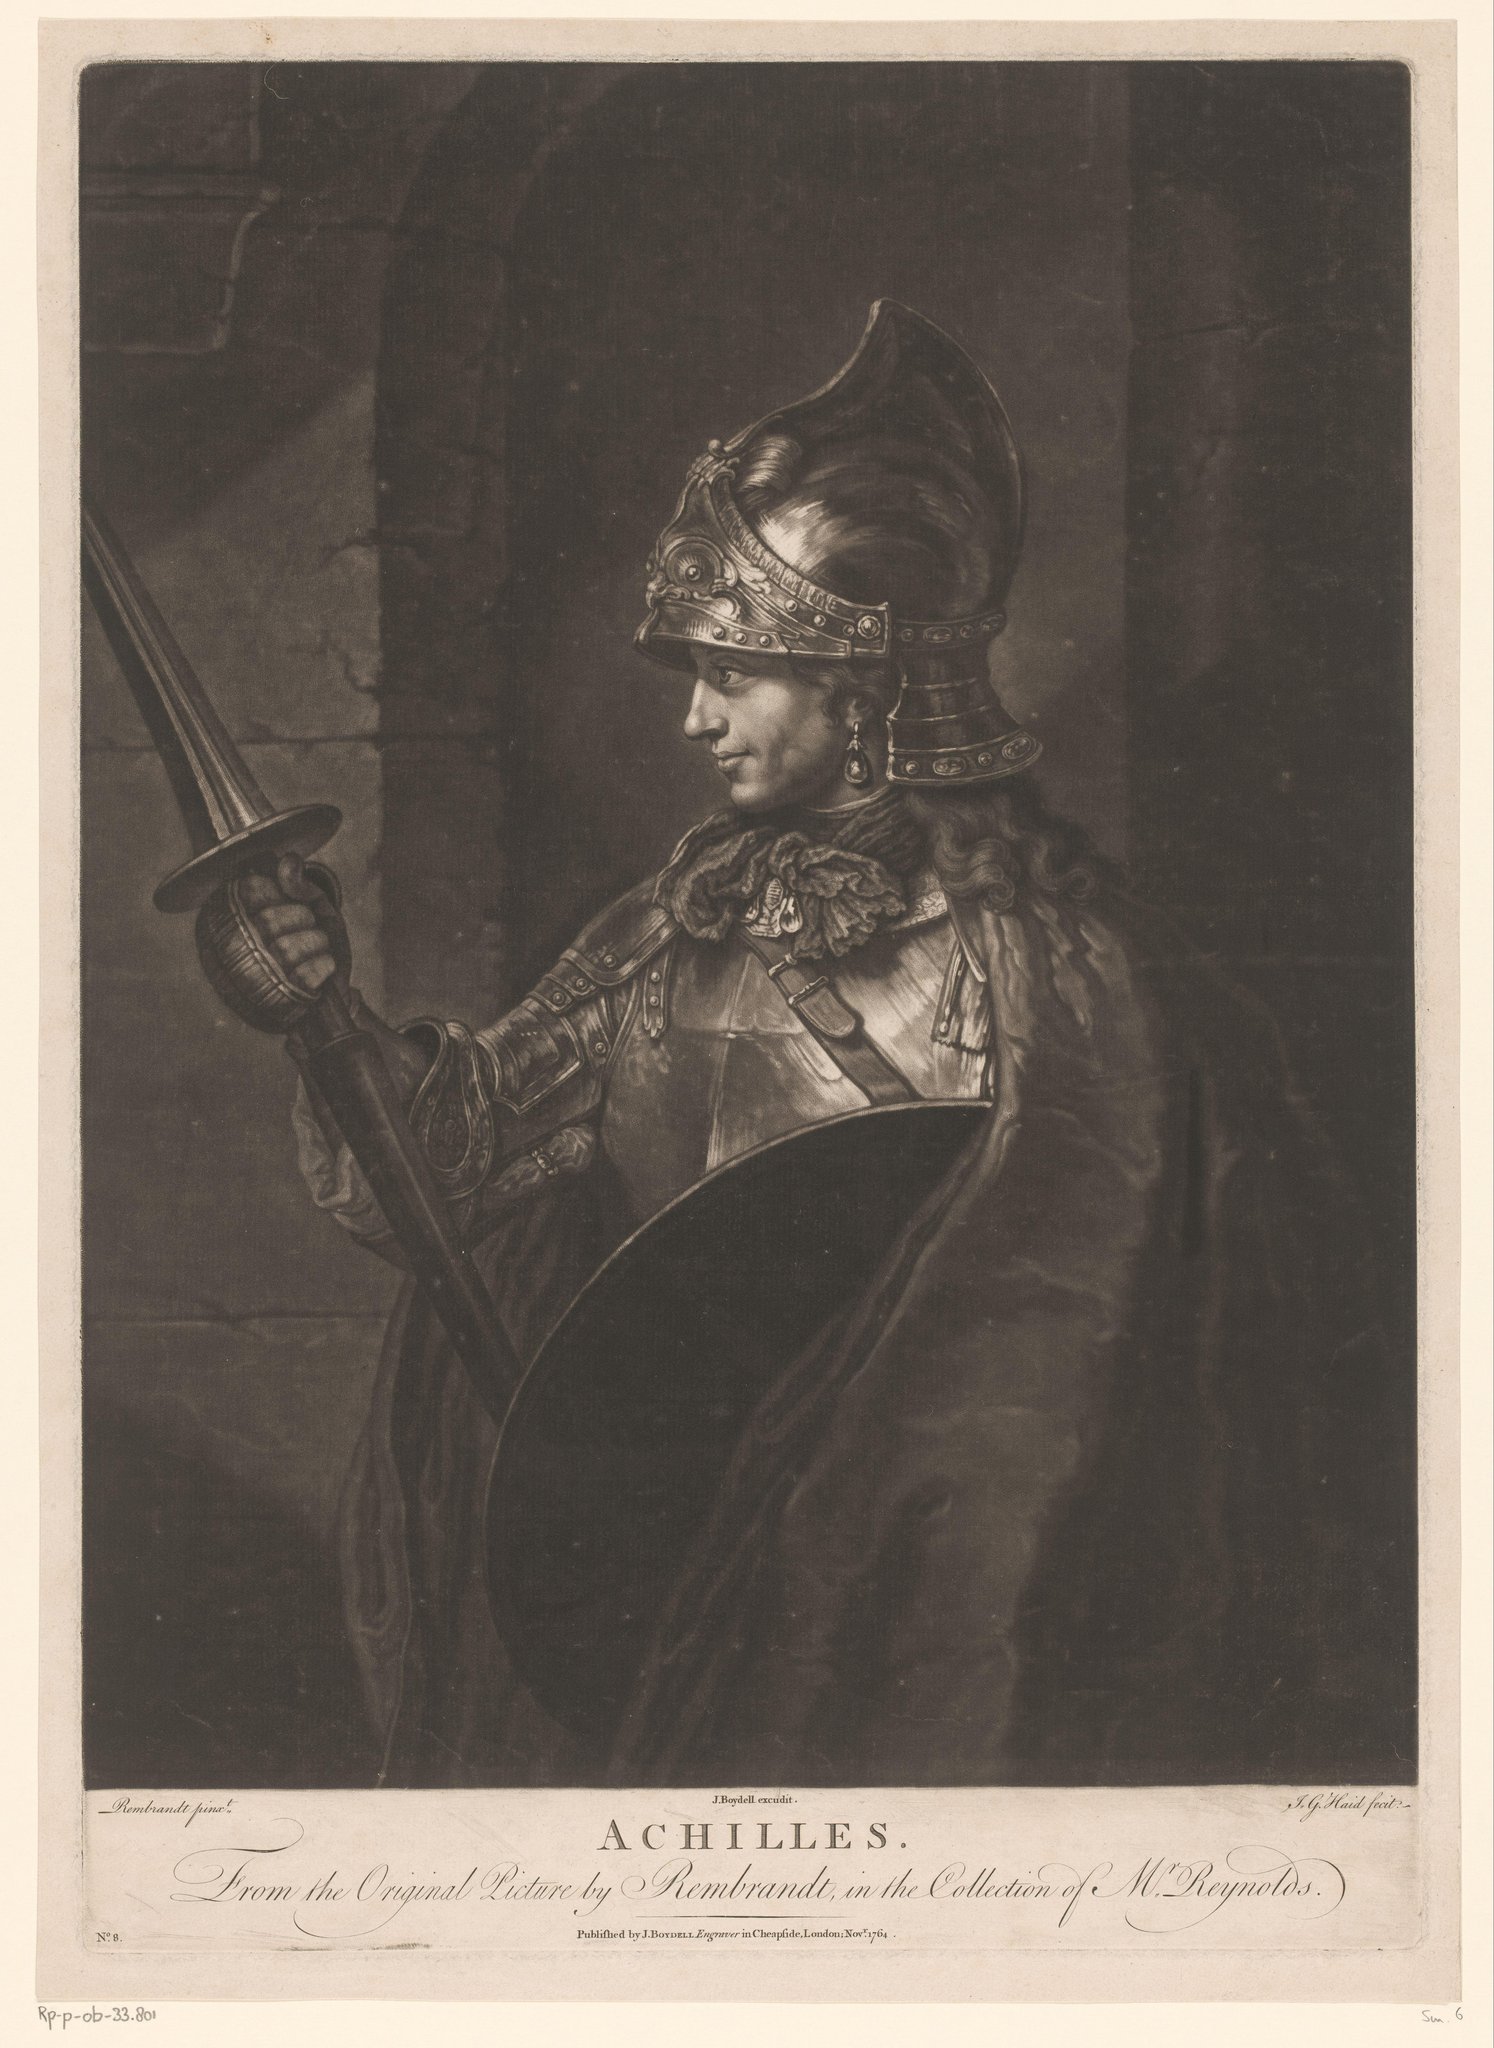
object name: print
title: Portret van Achilles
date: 1764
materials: paper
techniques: mezzotint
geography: château de villette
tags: armour, (story of) achilles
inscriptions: collector's mark: Lugt 240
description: Ten tijde van vervaardiging was het originele schilderij in bezit van Mr. Reynolds.